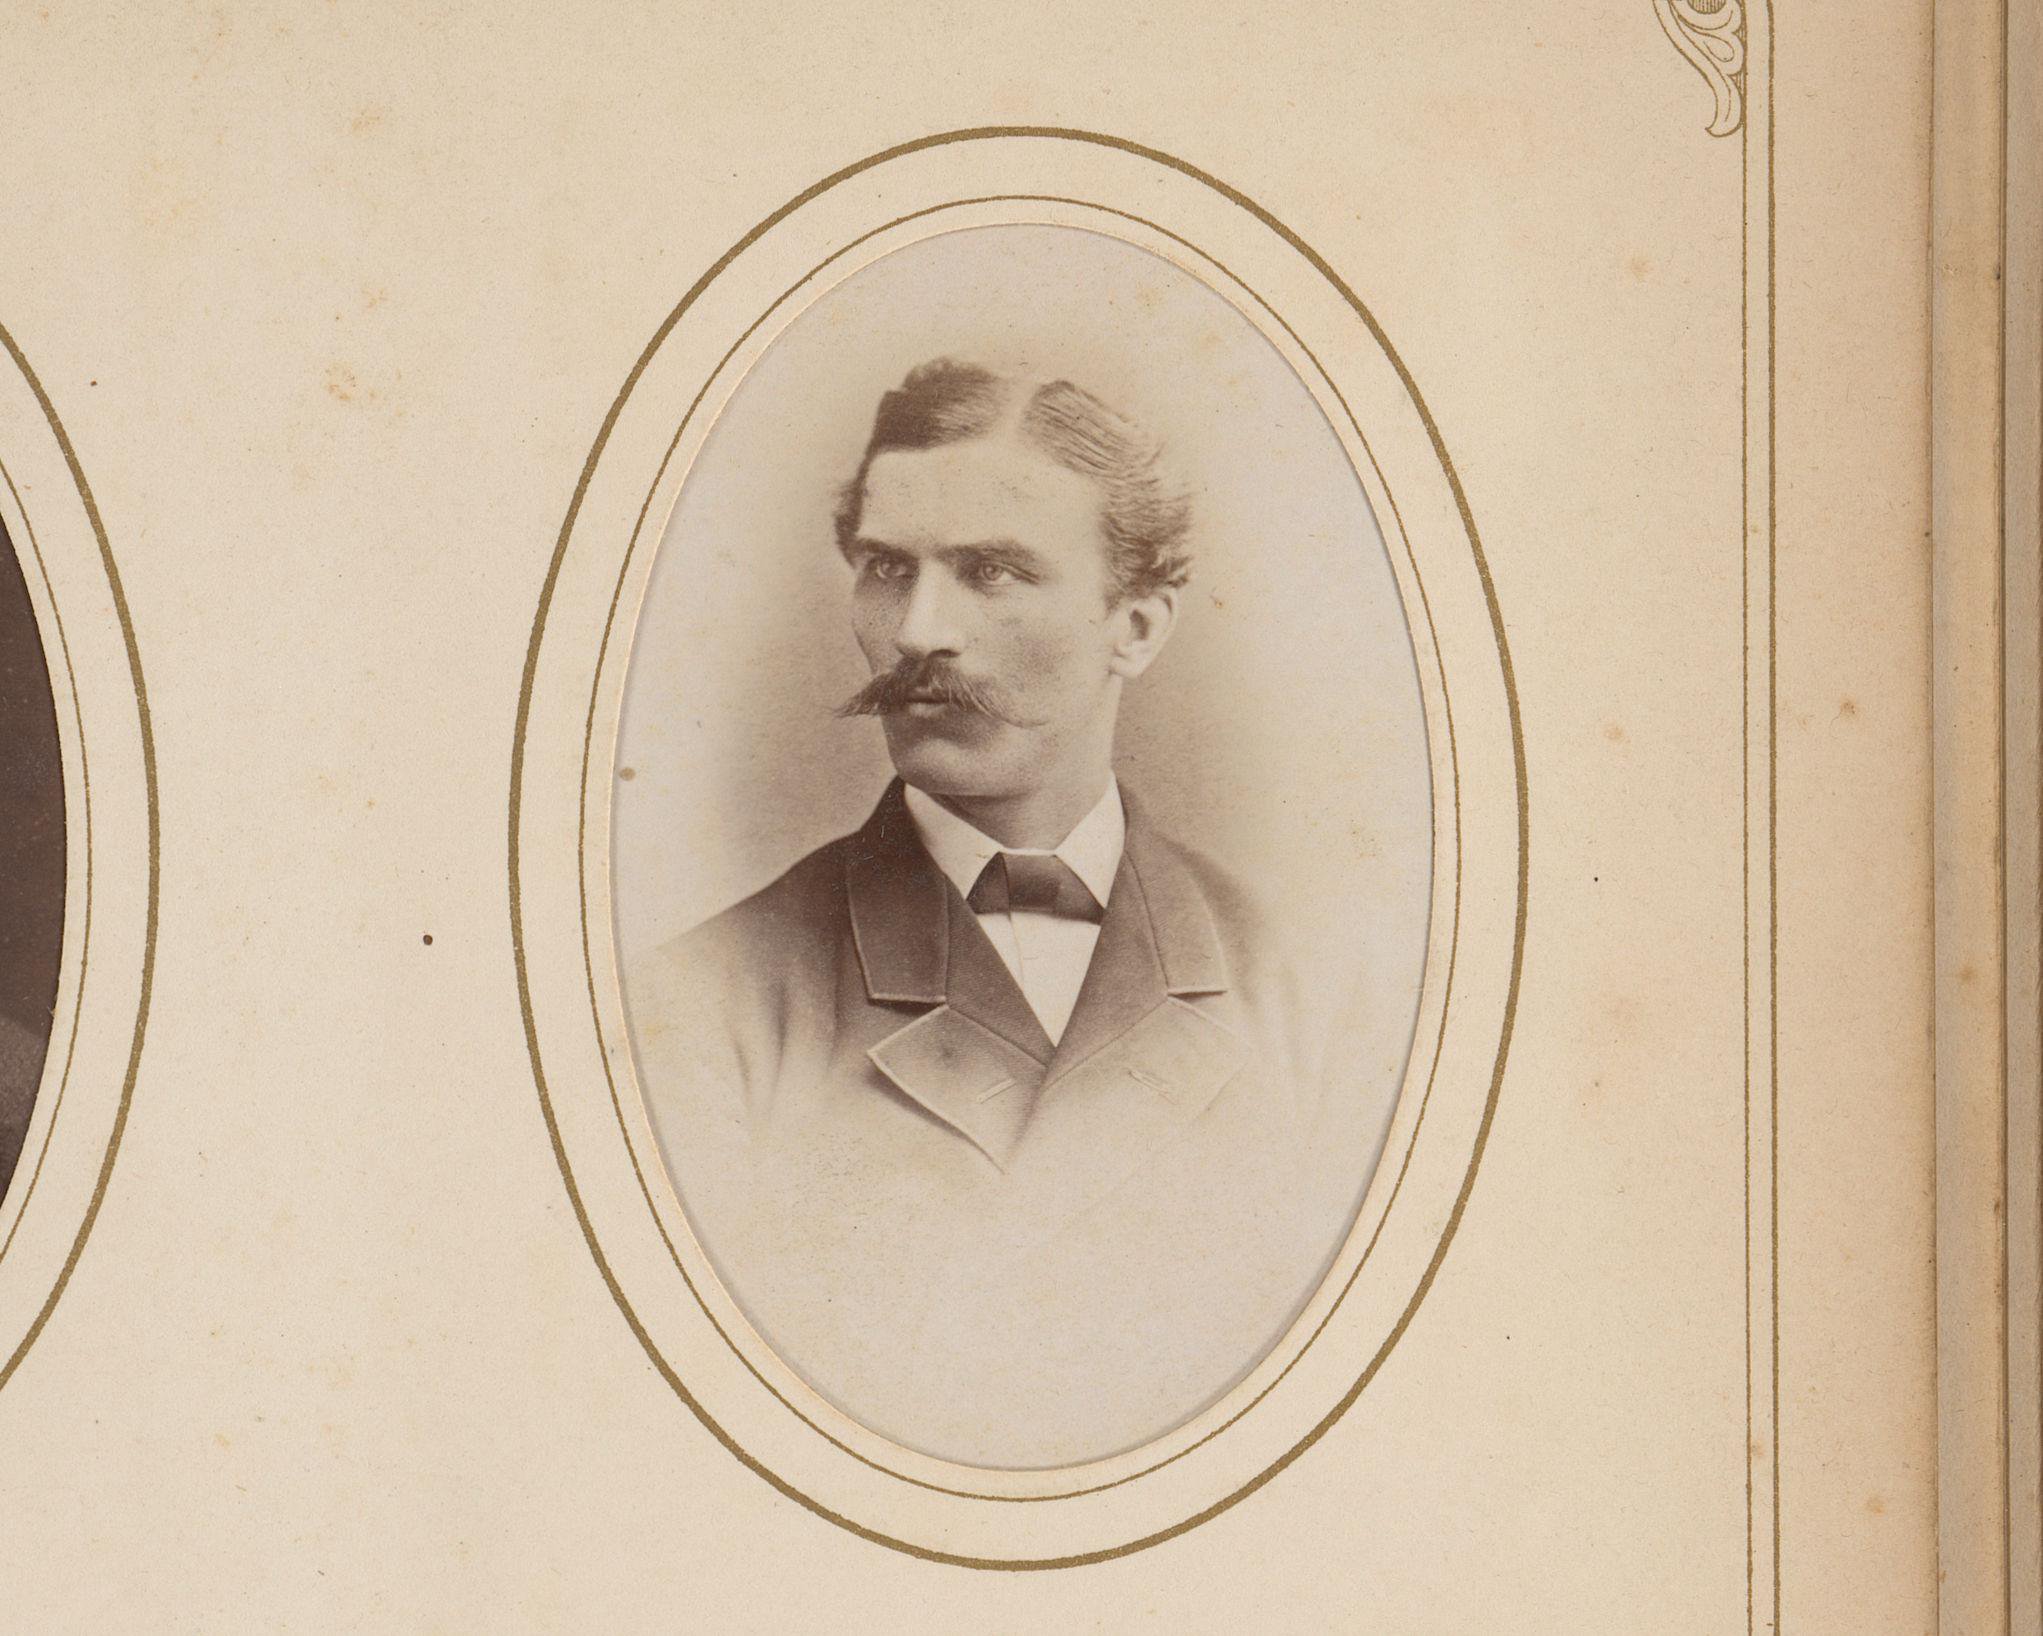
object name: album leaf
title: Portret van een man met snor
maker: max büttinghausen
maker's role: fotograaf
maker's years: 1847-1906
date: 1877-1895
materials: cardboard, photographic support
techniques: albumen print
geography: amsterdam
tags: moustache, historical persons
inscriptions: inscription: ‘Amsterdam/ 1877./ M. Büttinghausen/ Photographisch artistisch Atelier/ Singel b/d Torensteeg/ G 133/ Amsterdam/ Specialiteit in vergrootingen./ De plaat blijft ter nabestelling bewaard.’